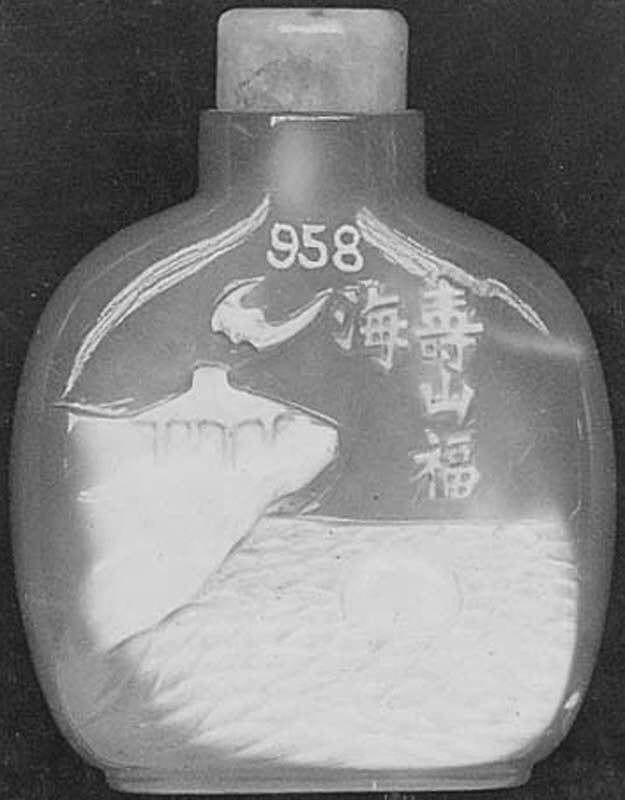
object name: snuff bottle with stopper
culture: chinese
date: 1701-1900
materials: stone, jade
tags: birds